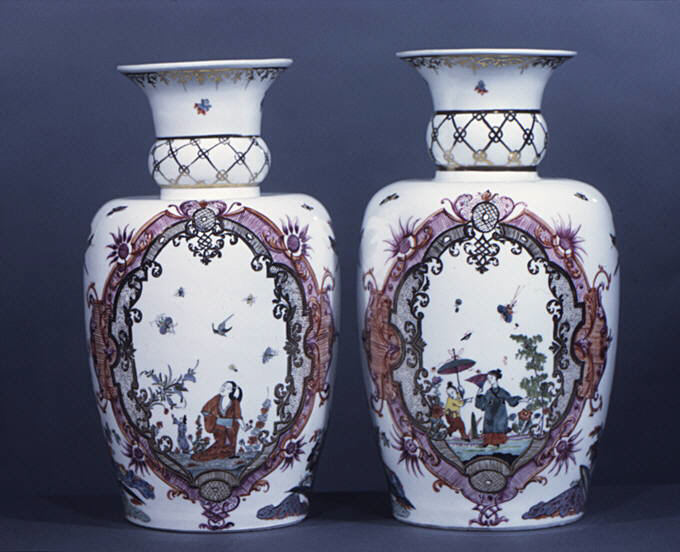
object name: vase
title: Vase (part of a set)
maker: meissen manufactory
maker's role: manufactory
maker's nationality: german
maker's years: 1710-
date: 1740-1750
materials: hard paste porcelain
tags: birds,chinoiserie,women,insects